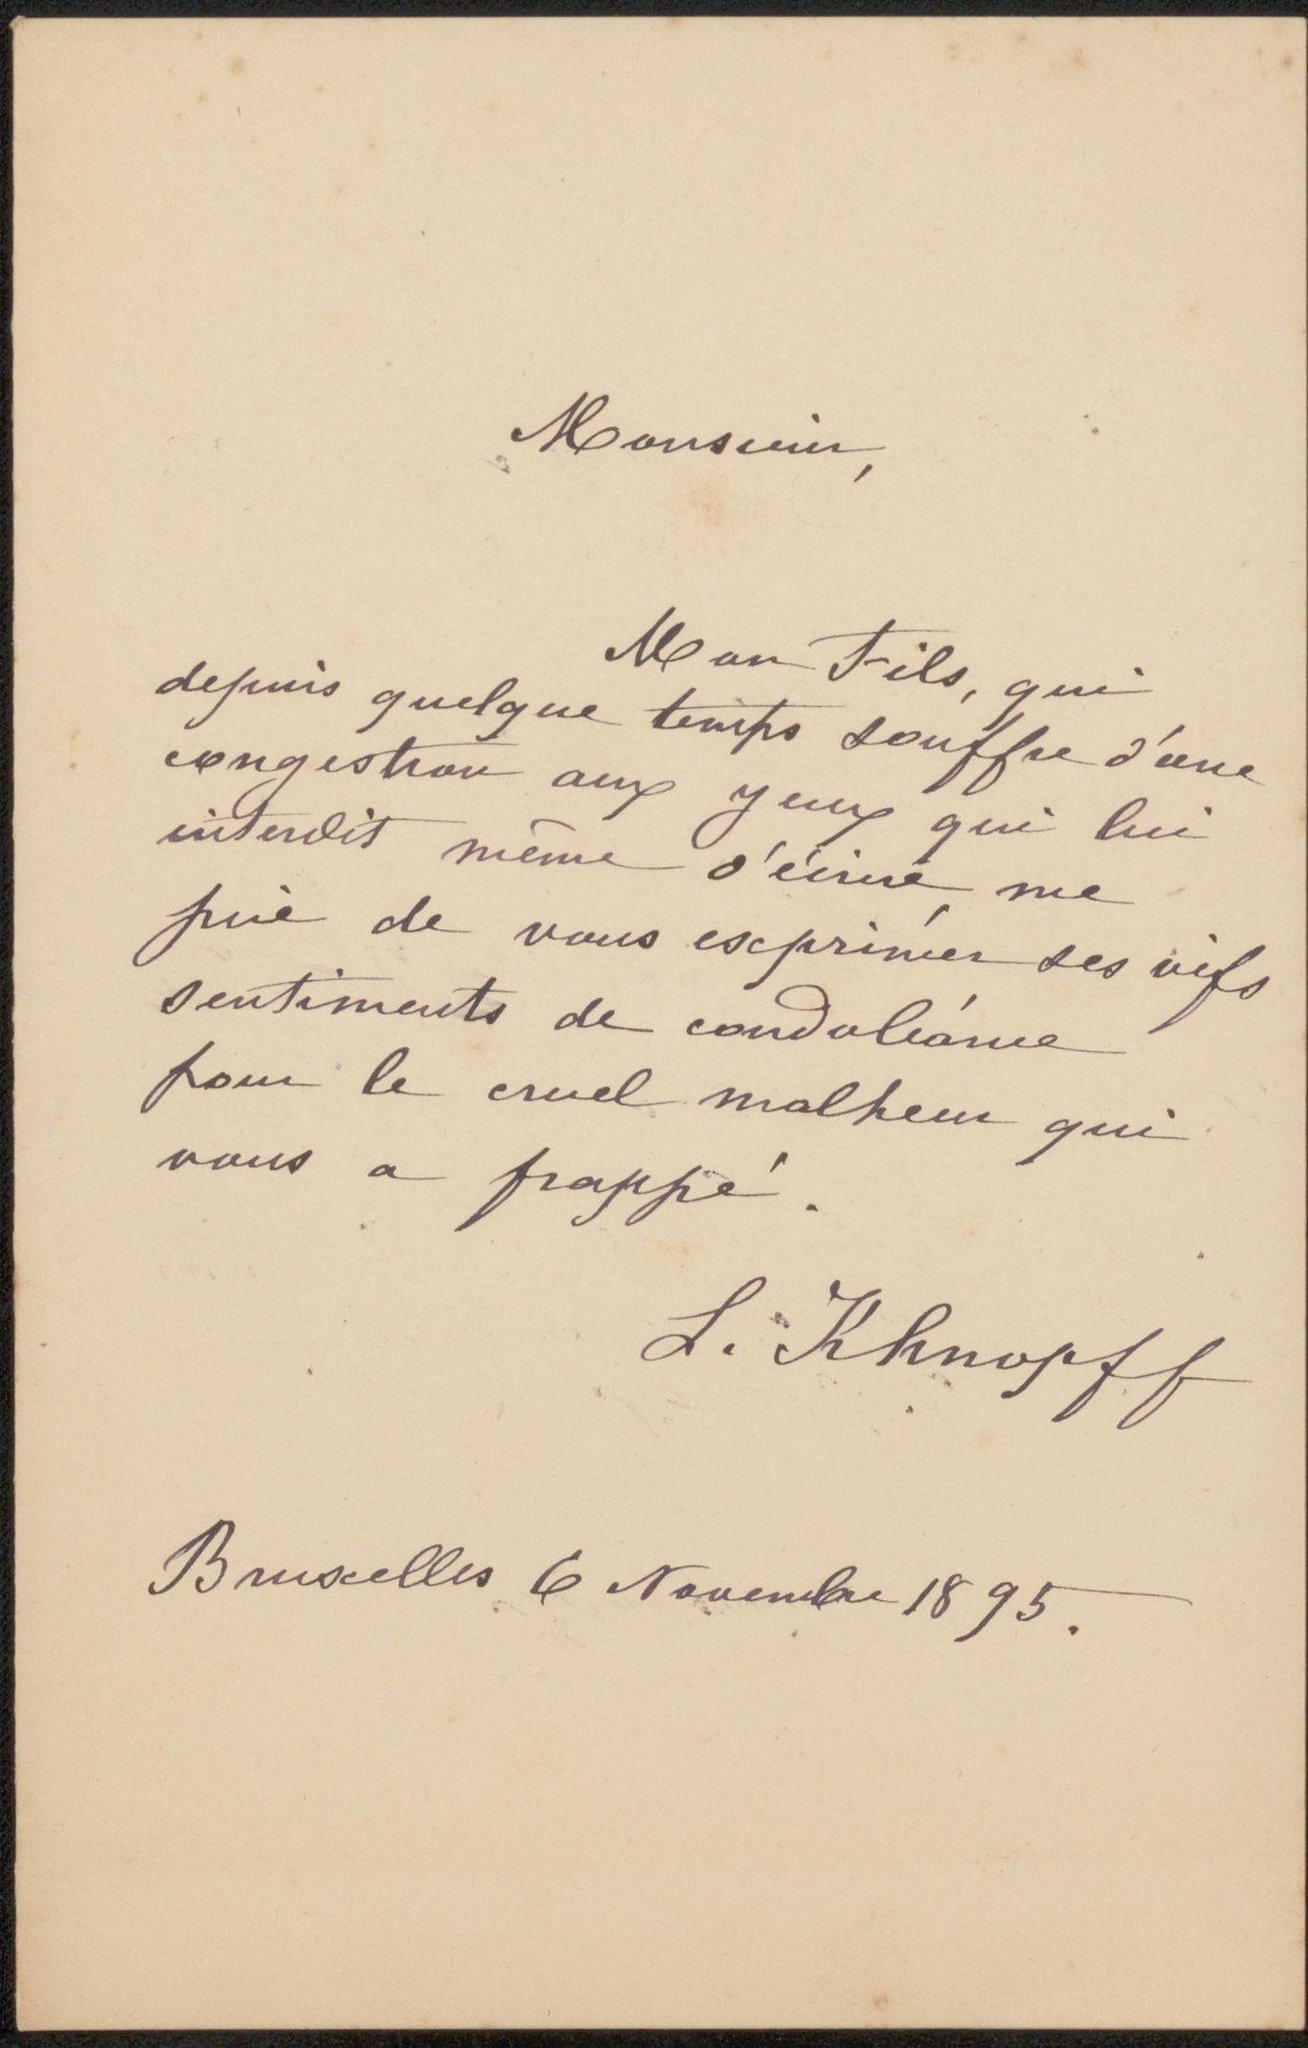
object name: letter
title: Brief aan Philip Zilcken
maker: fernand khnopff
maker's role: draughtsman, print maker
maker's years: 1858-1921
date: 1895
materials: ink, paper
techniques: pen, writing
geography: brussels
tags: helène lambertine hauzeur, the hague, painter, draughtsman, philip zilcken, passions, emotions, affections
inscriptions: watermark